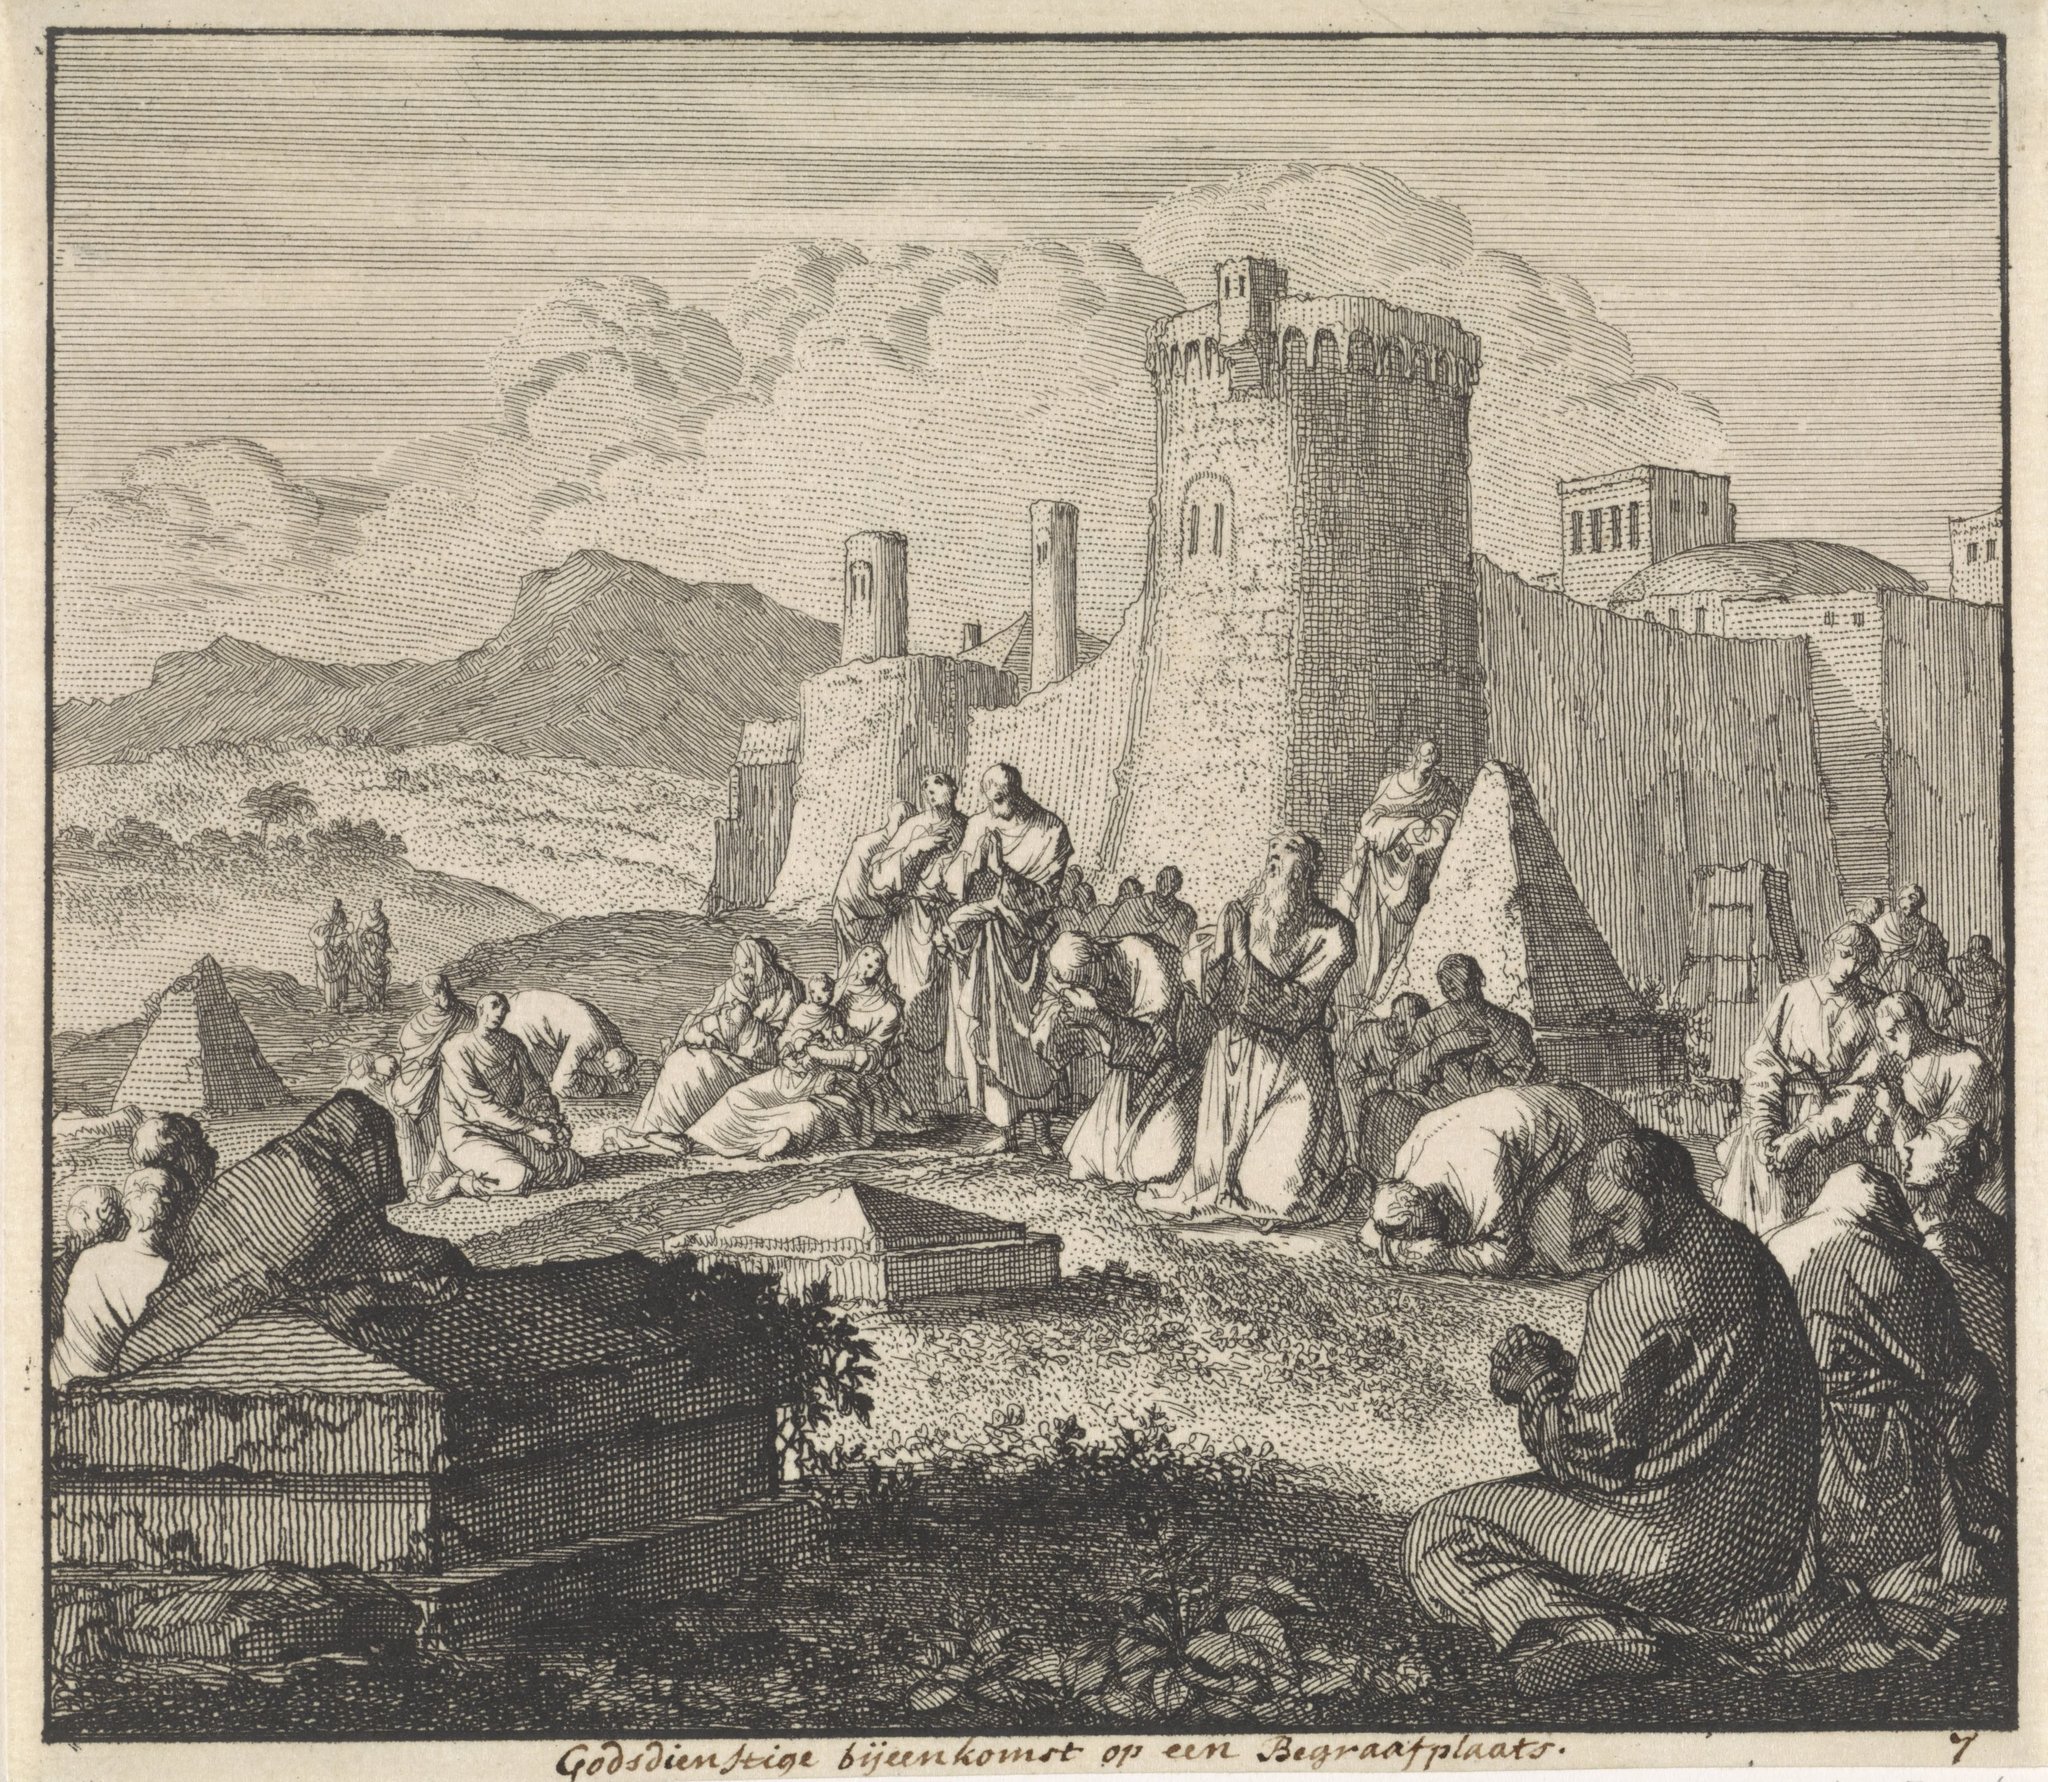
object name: print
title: Vroege Christenen komen samen bij een begraafplaats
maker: jan luyken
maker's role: draughtsman, print maker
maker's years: 1649-1712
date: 1700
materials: paper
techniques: etching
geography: amsterdam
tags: the early christian churches, e.g. armenians, copts, syrians, (public) prayer, city-walls, churchyard, cemetery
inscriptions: caption: ‘Godsdienstige byeenkomst op een Begraafplaats’, collector's mark: Lugt 2228, number: ‘7’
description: Proefdruk van een boekillustratie voor Arnold, Godfried. Waare afbeelding der eerste christenen. Amsterdam: Jacobus van Hardenberg, Barent Visscher en Jacobus van Nieuweveen, 1700, dl. 1.